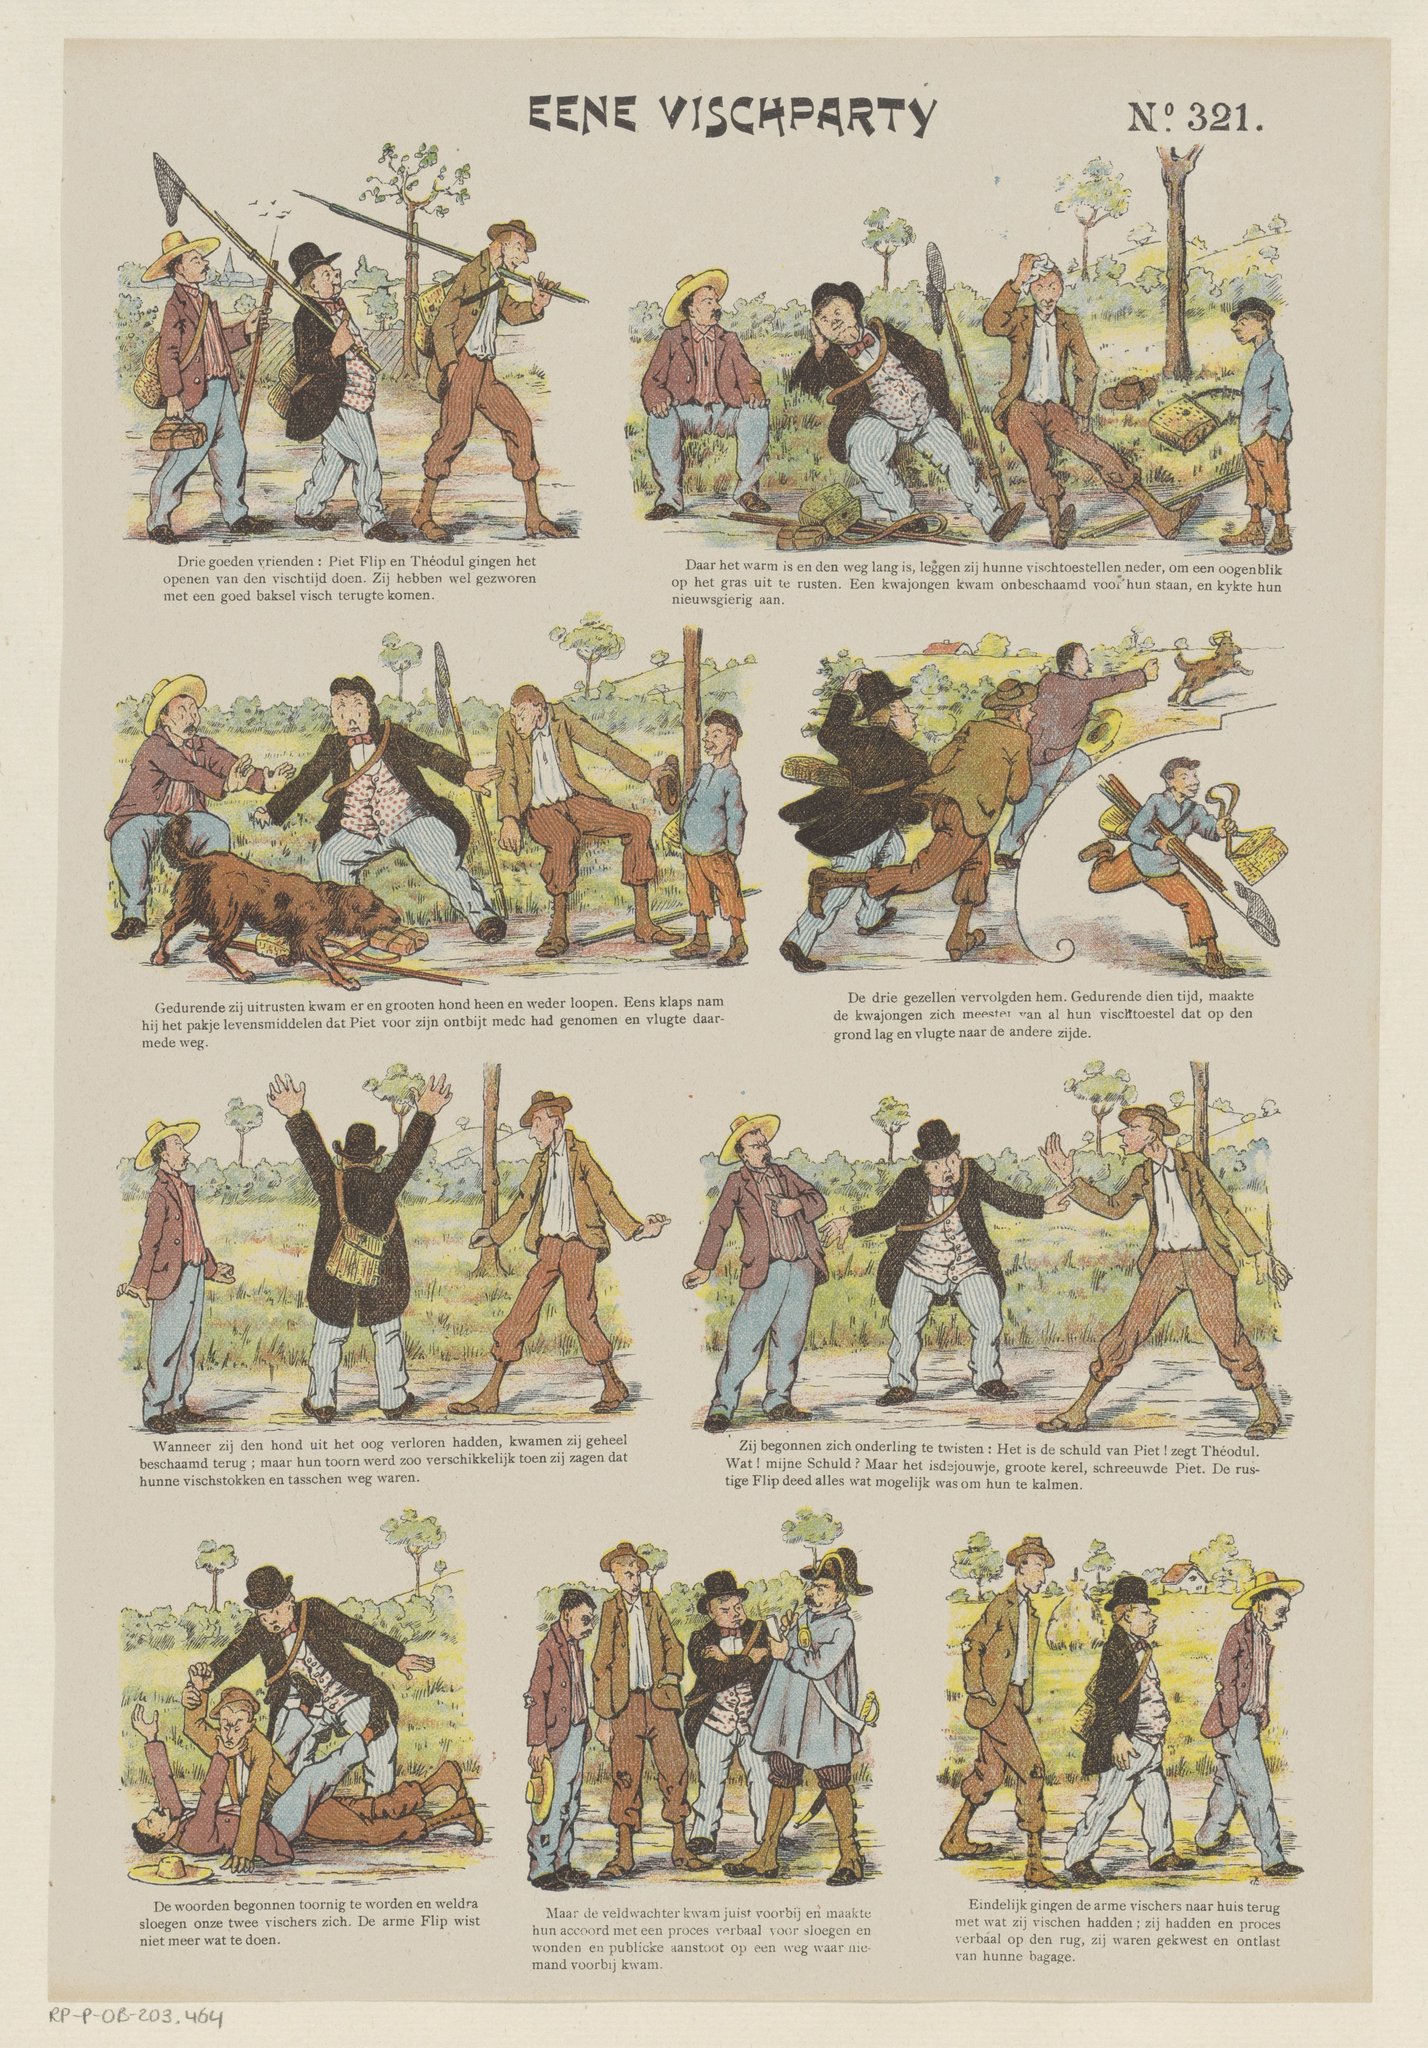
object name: popular print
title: Eene vischparty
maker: Anonymous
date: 1894-1959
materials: paper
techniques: lithograph, letterpress printing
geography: liège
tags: quarrel, argument, fishing (sports) (+ fishing equipment), friends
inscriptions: collector's mark: Lugt 2760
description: Blad met 9 voorstellingen over de drie goede vrienden, Piet, Flip en Théodul, die op weg naar de visvijver beroofd worden van hun spullen. Onder elke afbeelding een onderschrift. Genummerd rechtsboven: No 321.